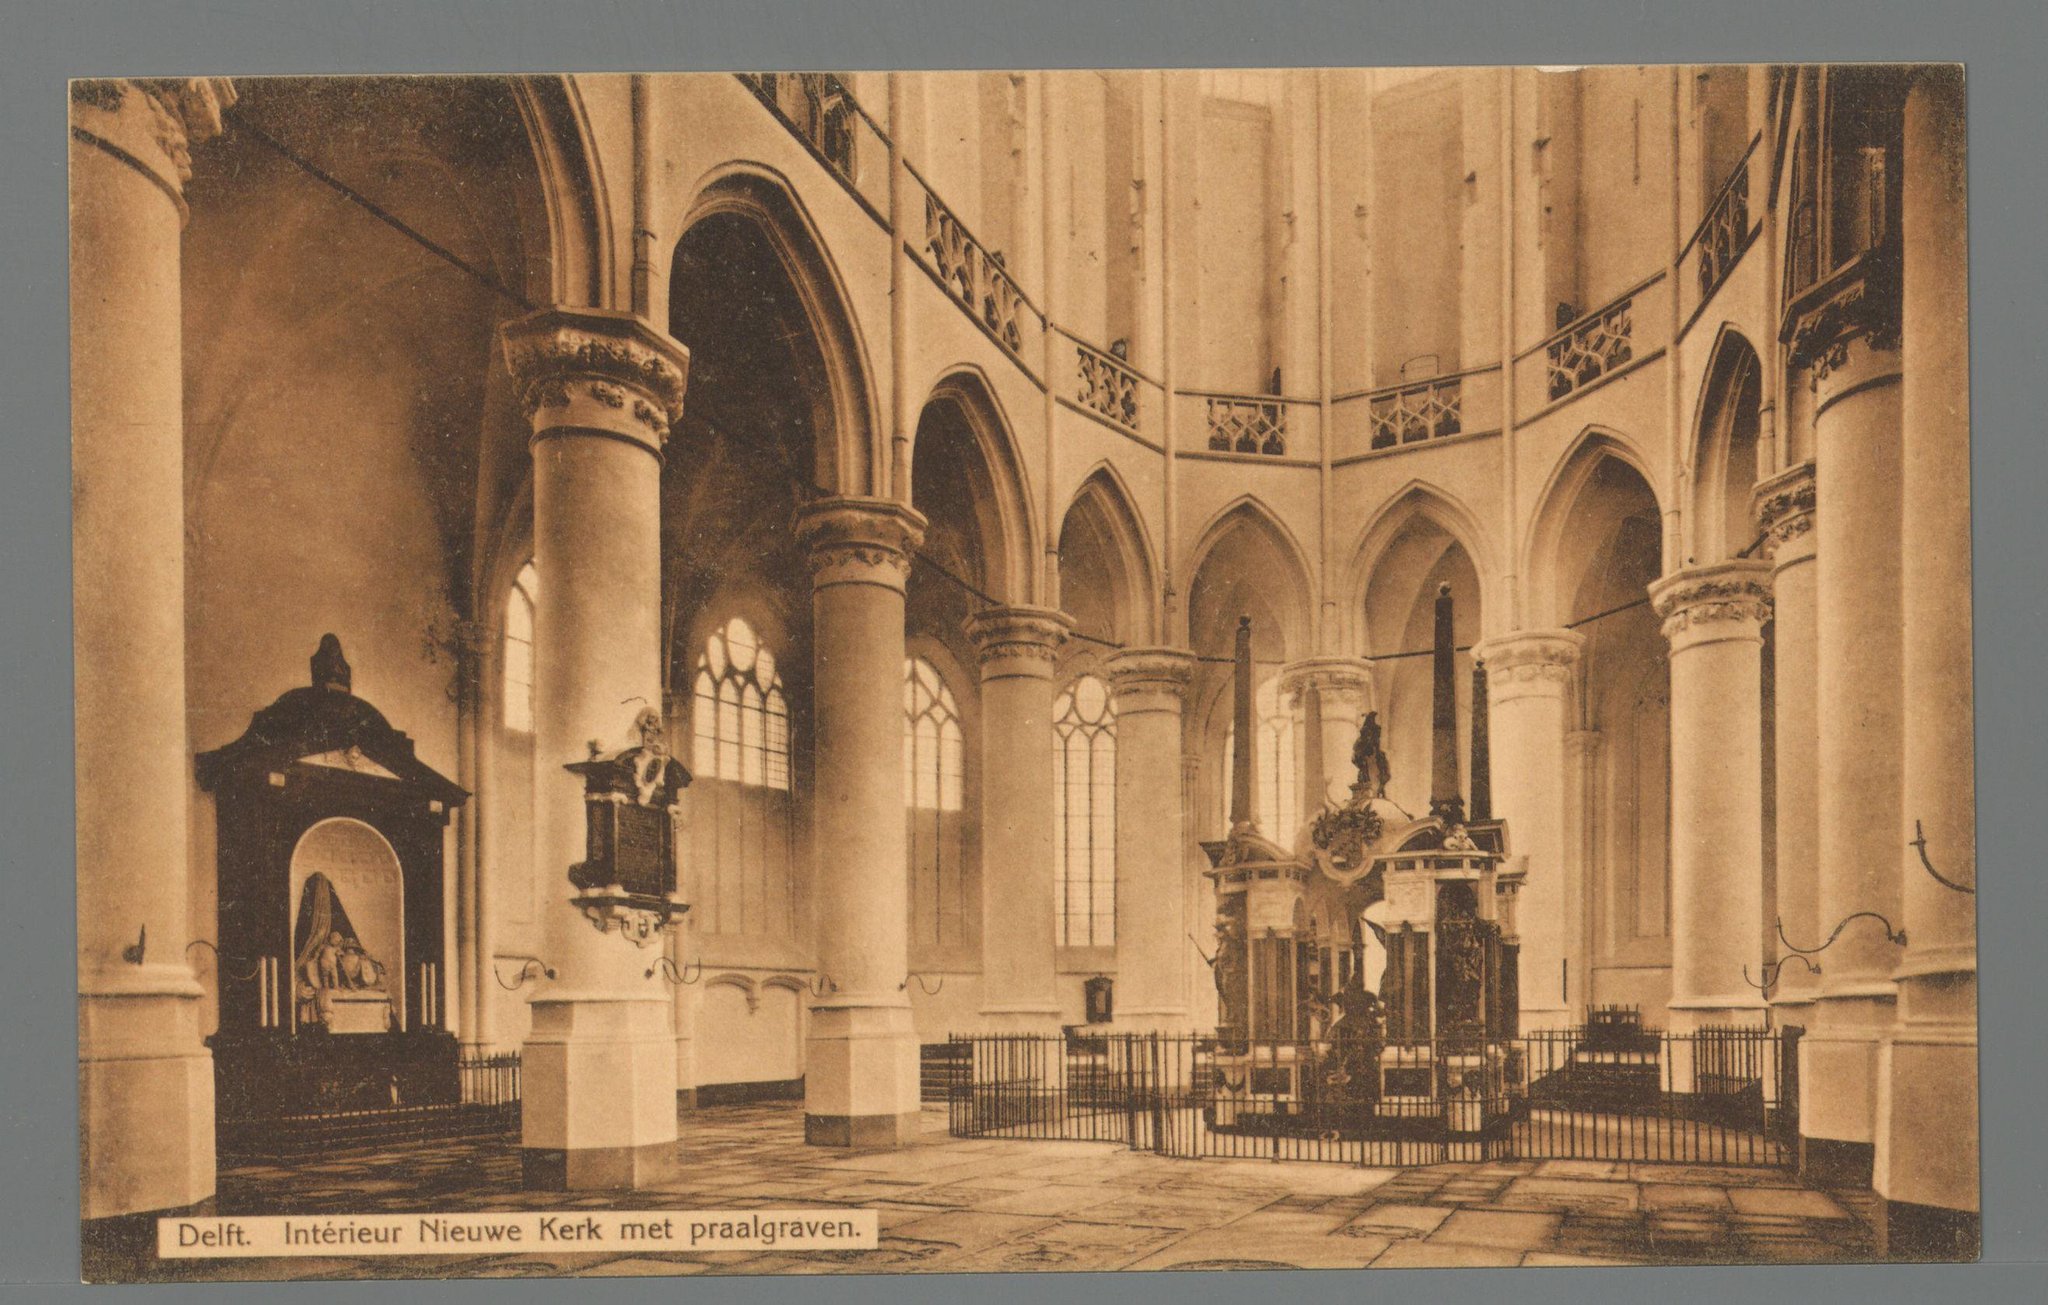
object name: ansichtkaart, prentbriefkaart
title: Delft. Intérieur Nieuwe Kerk met praalgraven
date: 1912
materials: cardboard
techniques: photograph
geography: delft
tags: delft, william i (prince of orange), interior of church, grave-building, monumental tomb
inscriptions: date